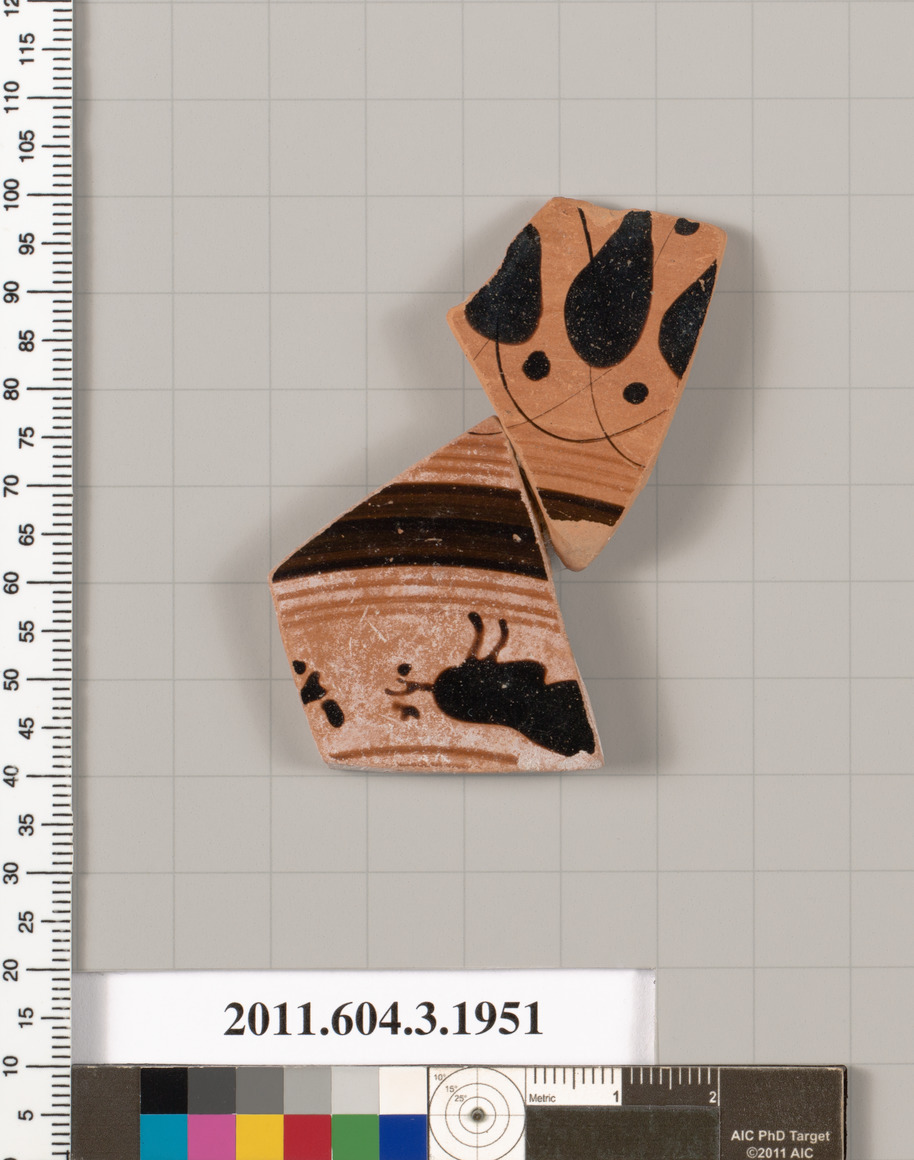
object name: kylix fragment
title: Terracotta fragment of a kylix: Droop cup (drinking cup)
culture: greek, attic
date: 567-535 BCE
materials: terracotta